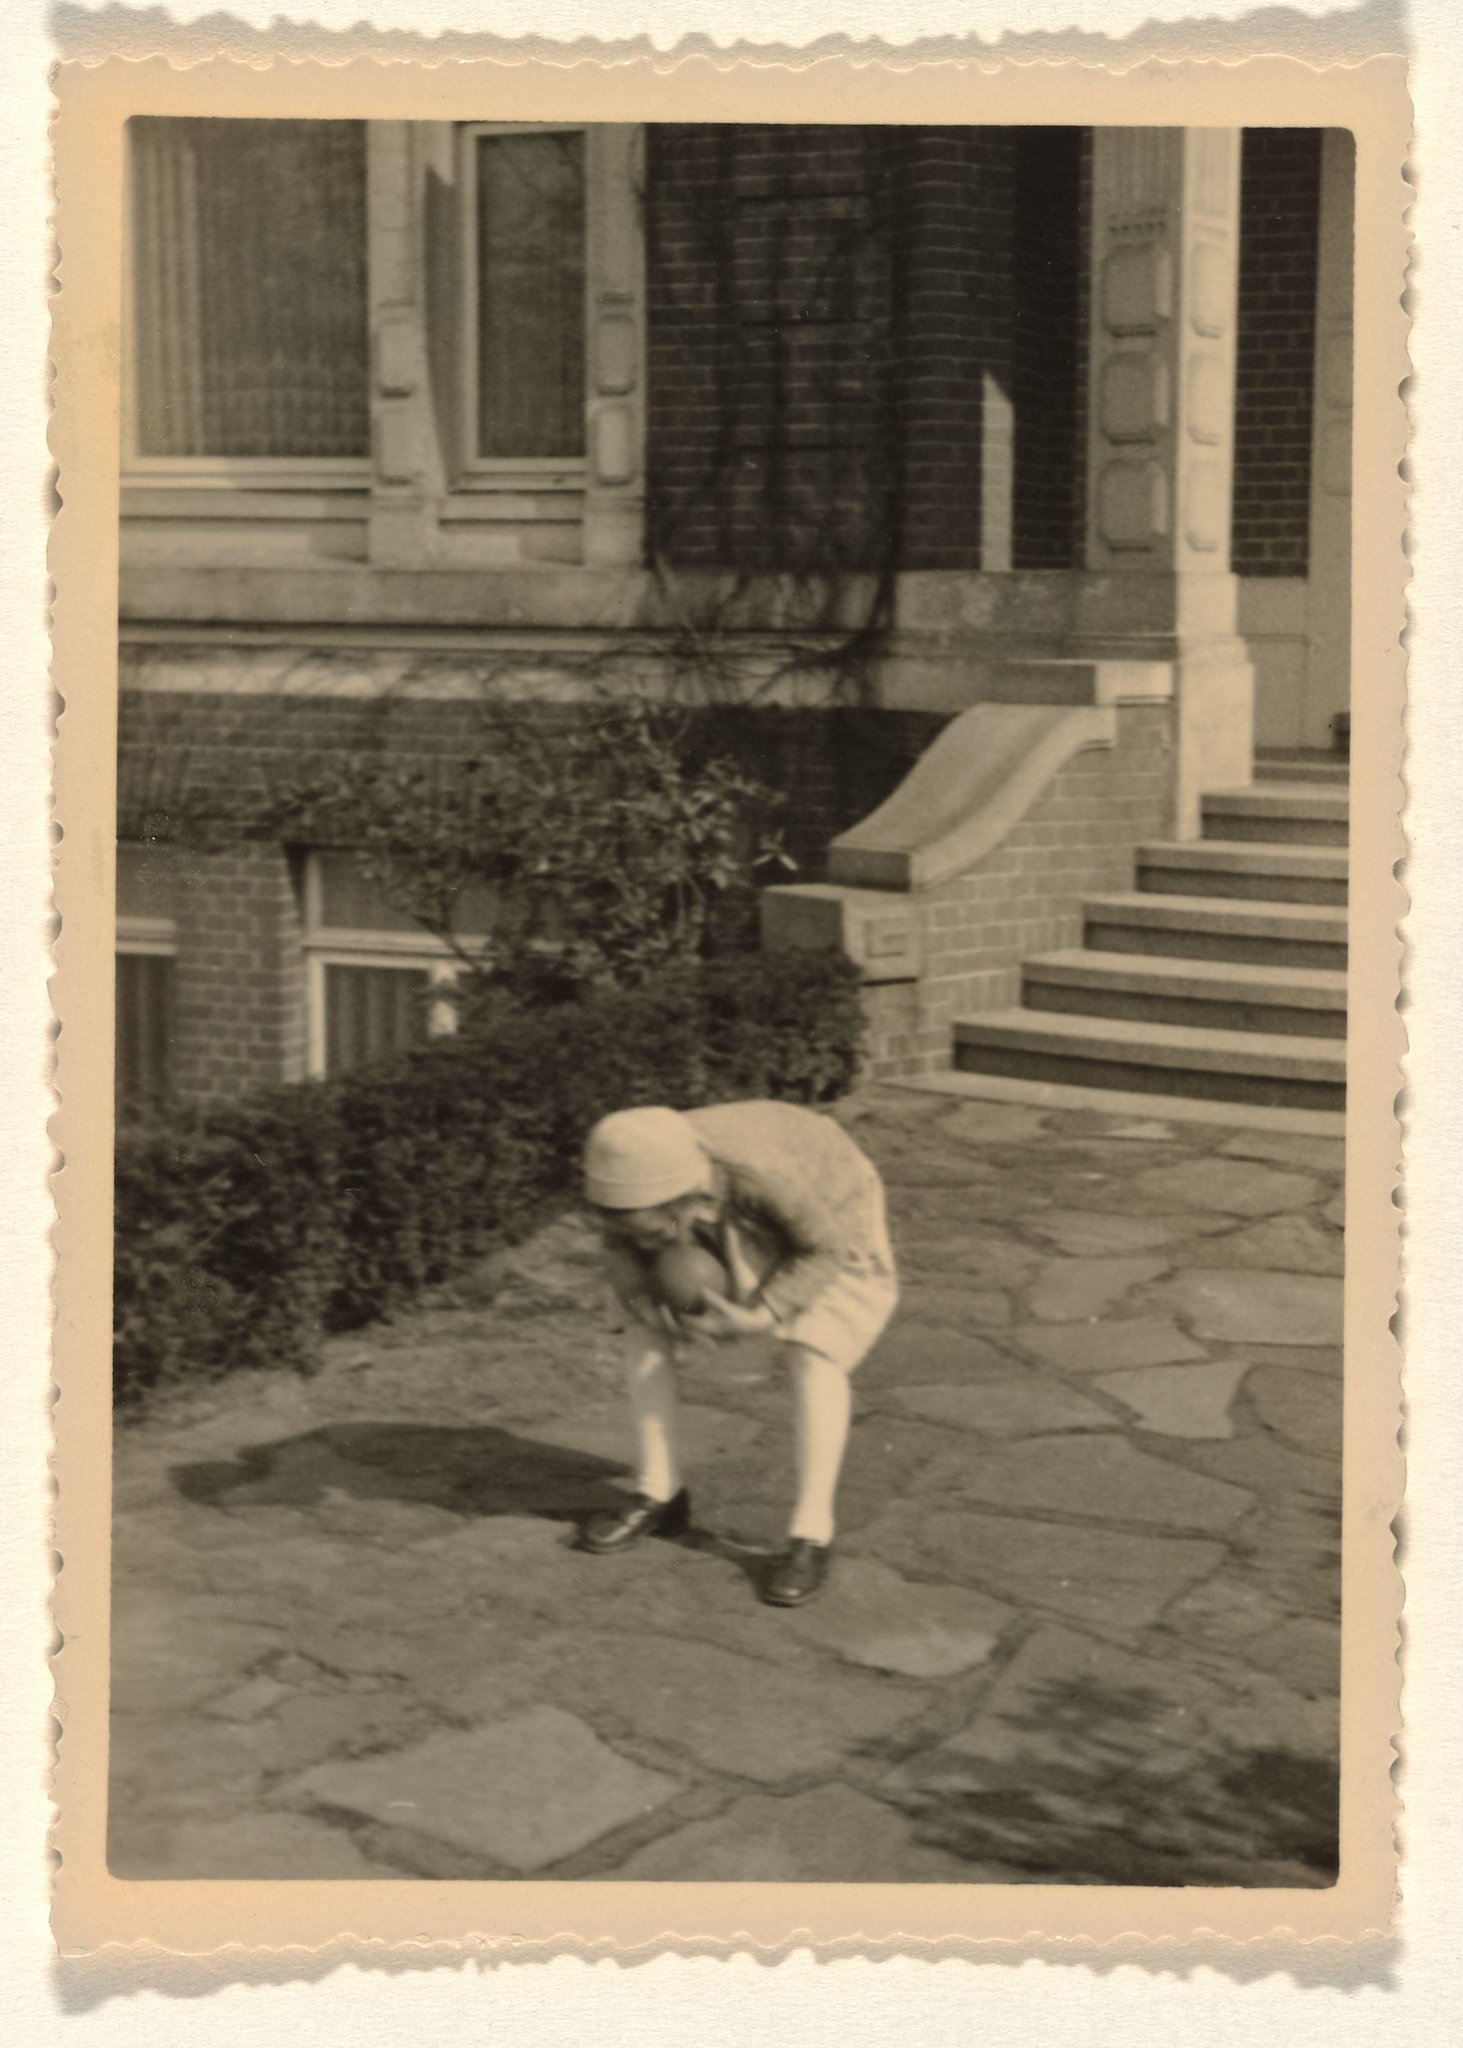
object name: photograph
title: Isabel Wachenheimer, Hamburg, 1935, Bellevue 62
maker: Anonymous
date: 1935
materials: photographic support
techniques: gelatin silver print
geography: hamburg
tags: leiden, isabel wachenheimer-elon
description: Dit object is onderdeel van de nalatenschap van Isabel Elon-Wachenheimer (1928-2010). Tot haar overlijden behoorde het samen met de andere objecten uit de nalatenschap tot haar privédomein van Isabel Wachenheimer. In die particuliere context zijn deze objecten tezamen en individueel aandenkens - aan de jeugd, ouders en familie van Isabel Wachenheimer vóór en tijdens de Shoah en aan haar leven na de Tweede Wereldoorlog. Isabel Wachenheimer, die van juni 1943 tot mei 1945 gevangen zat in Kamp Westerbork, Theresienstadt, Auschwitz, Lenzing a/d Oberdonau (een buitenkamp van Mauthausen), overleefde de Shoah. Haar ouders – Eugène Wachenheimer en Else Wachenheimer-Moos - werden op 14 oktober 1944 in Auschwitz-Birkenau vermoord.